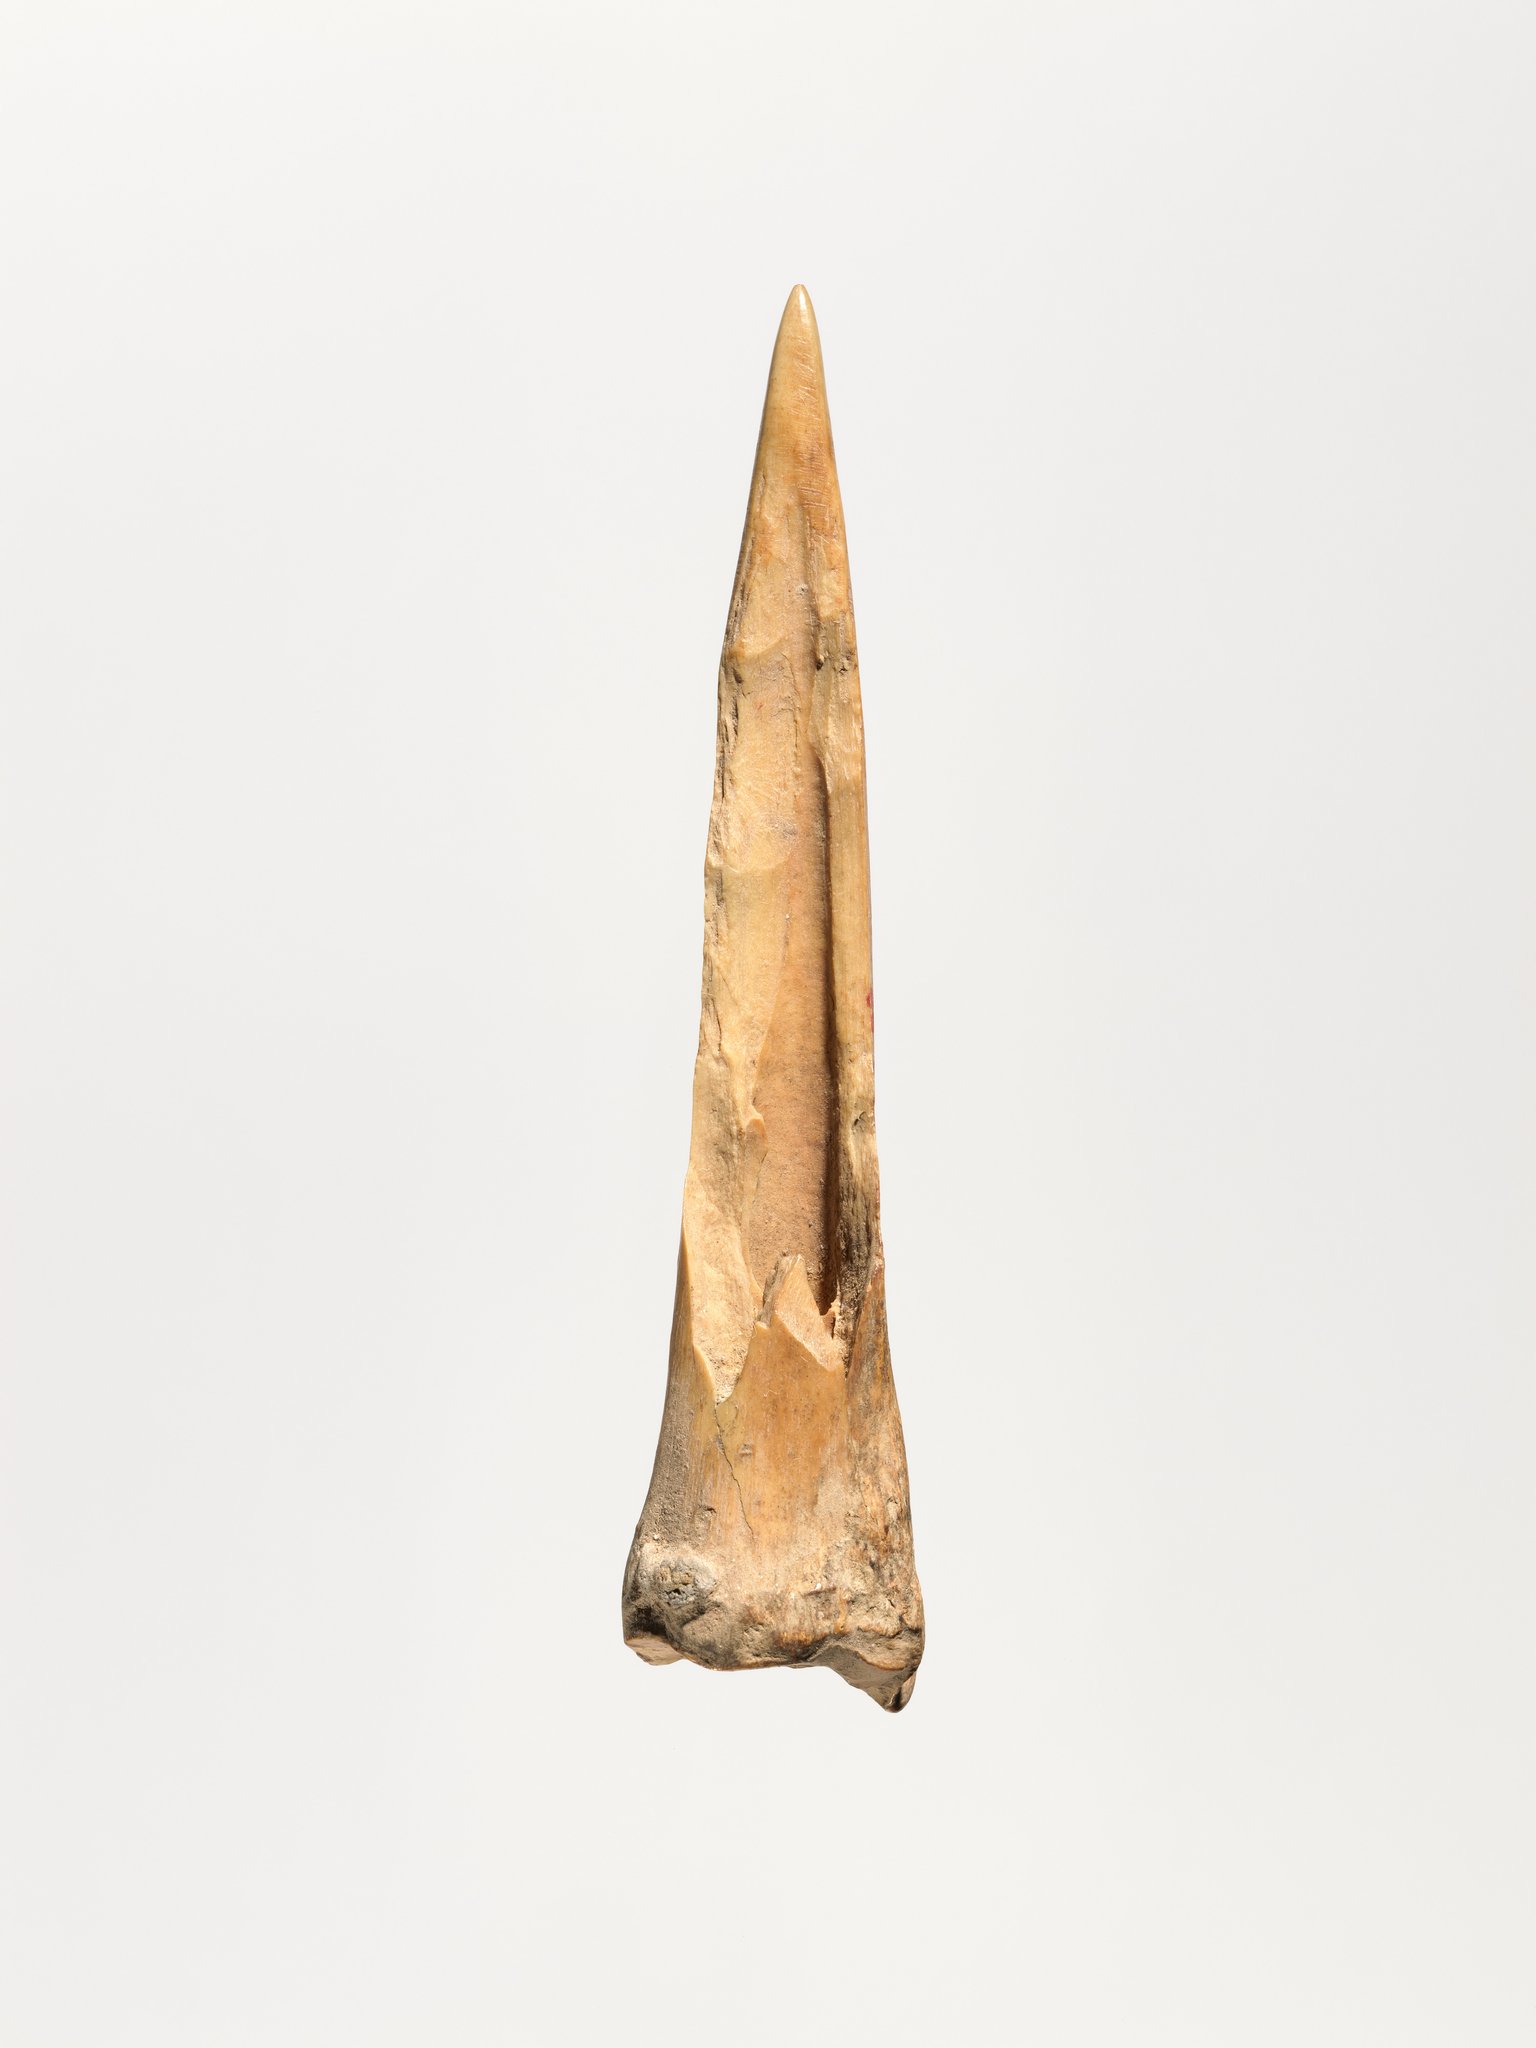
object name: awl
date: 3100-2900 BCE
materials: bone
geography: mesopotamia